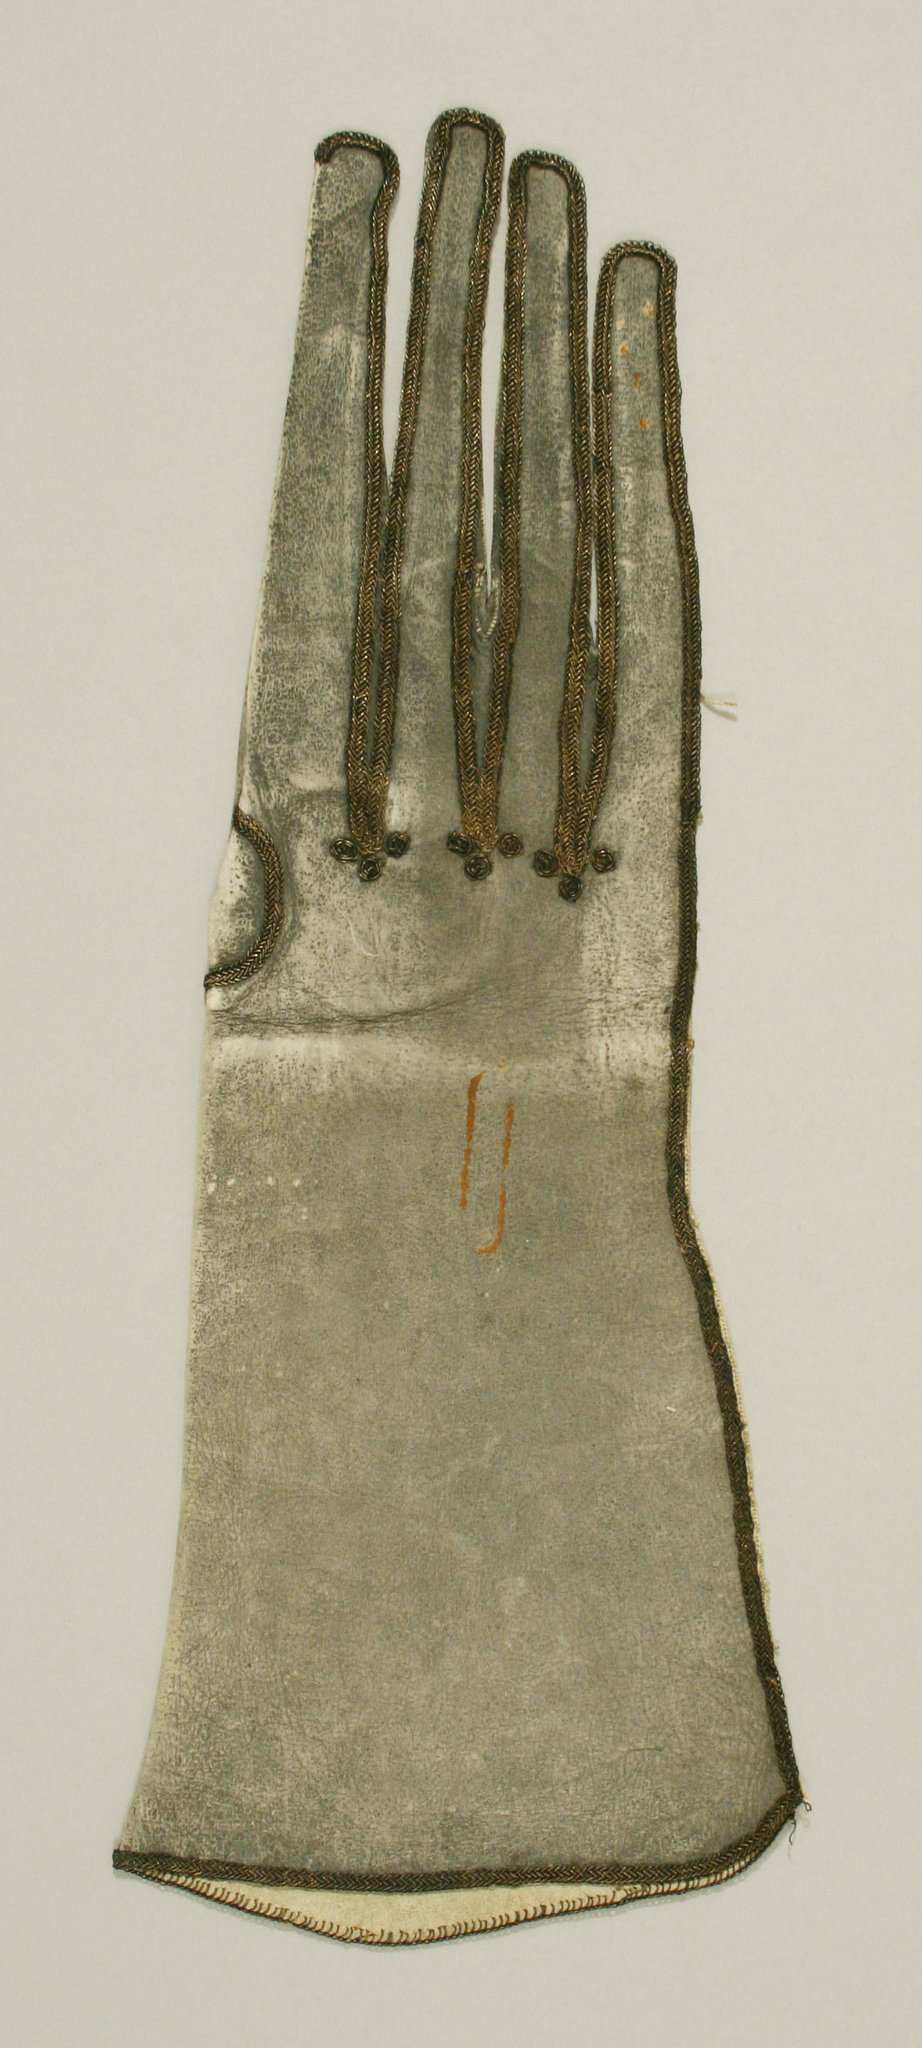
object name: glove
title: Gloves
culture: british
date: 1601-1700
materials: leather